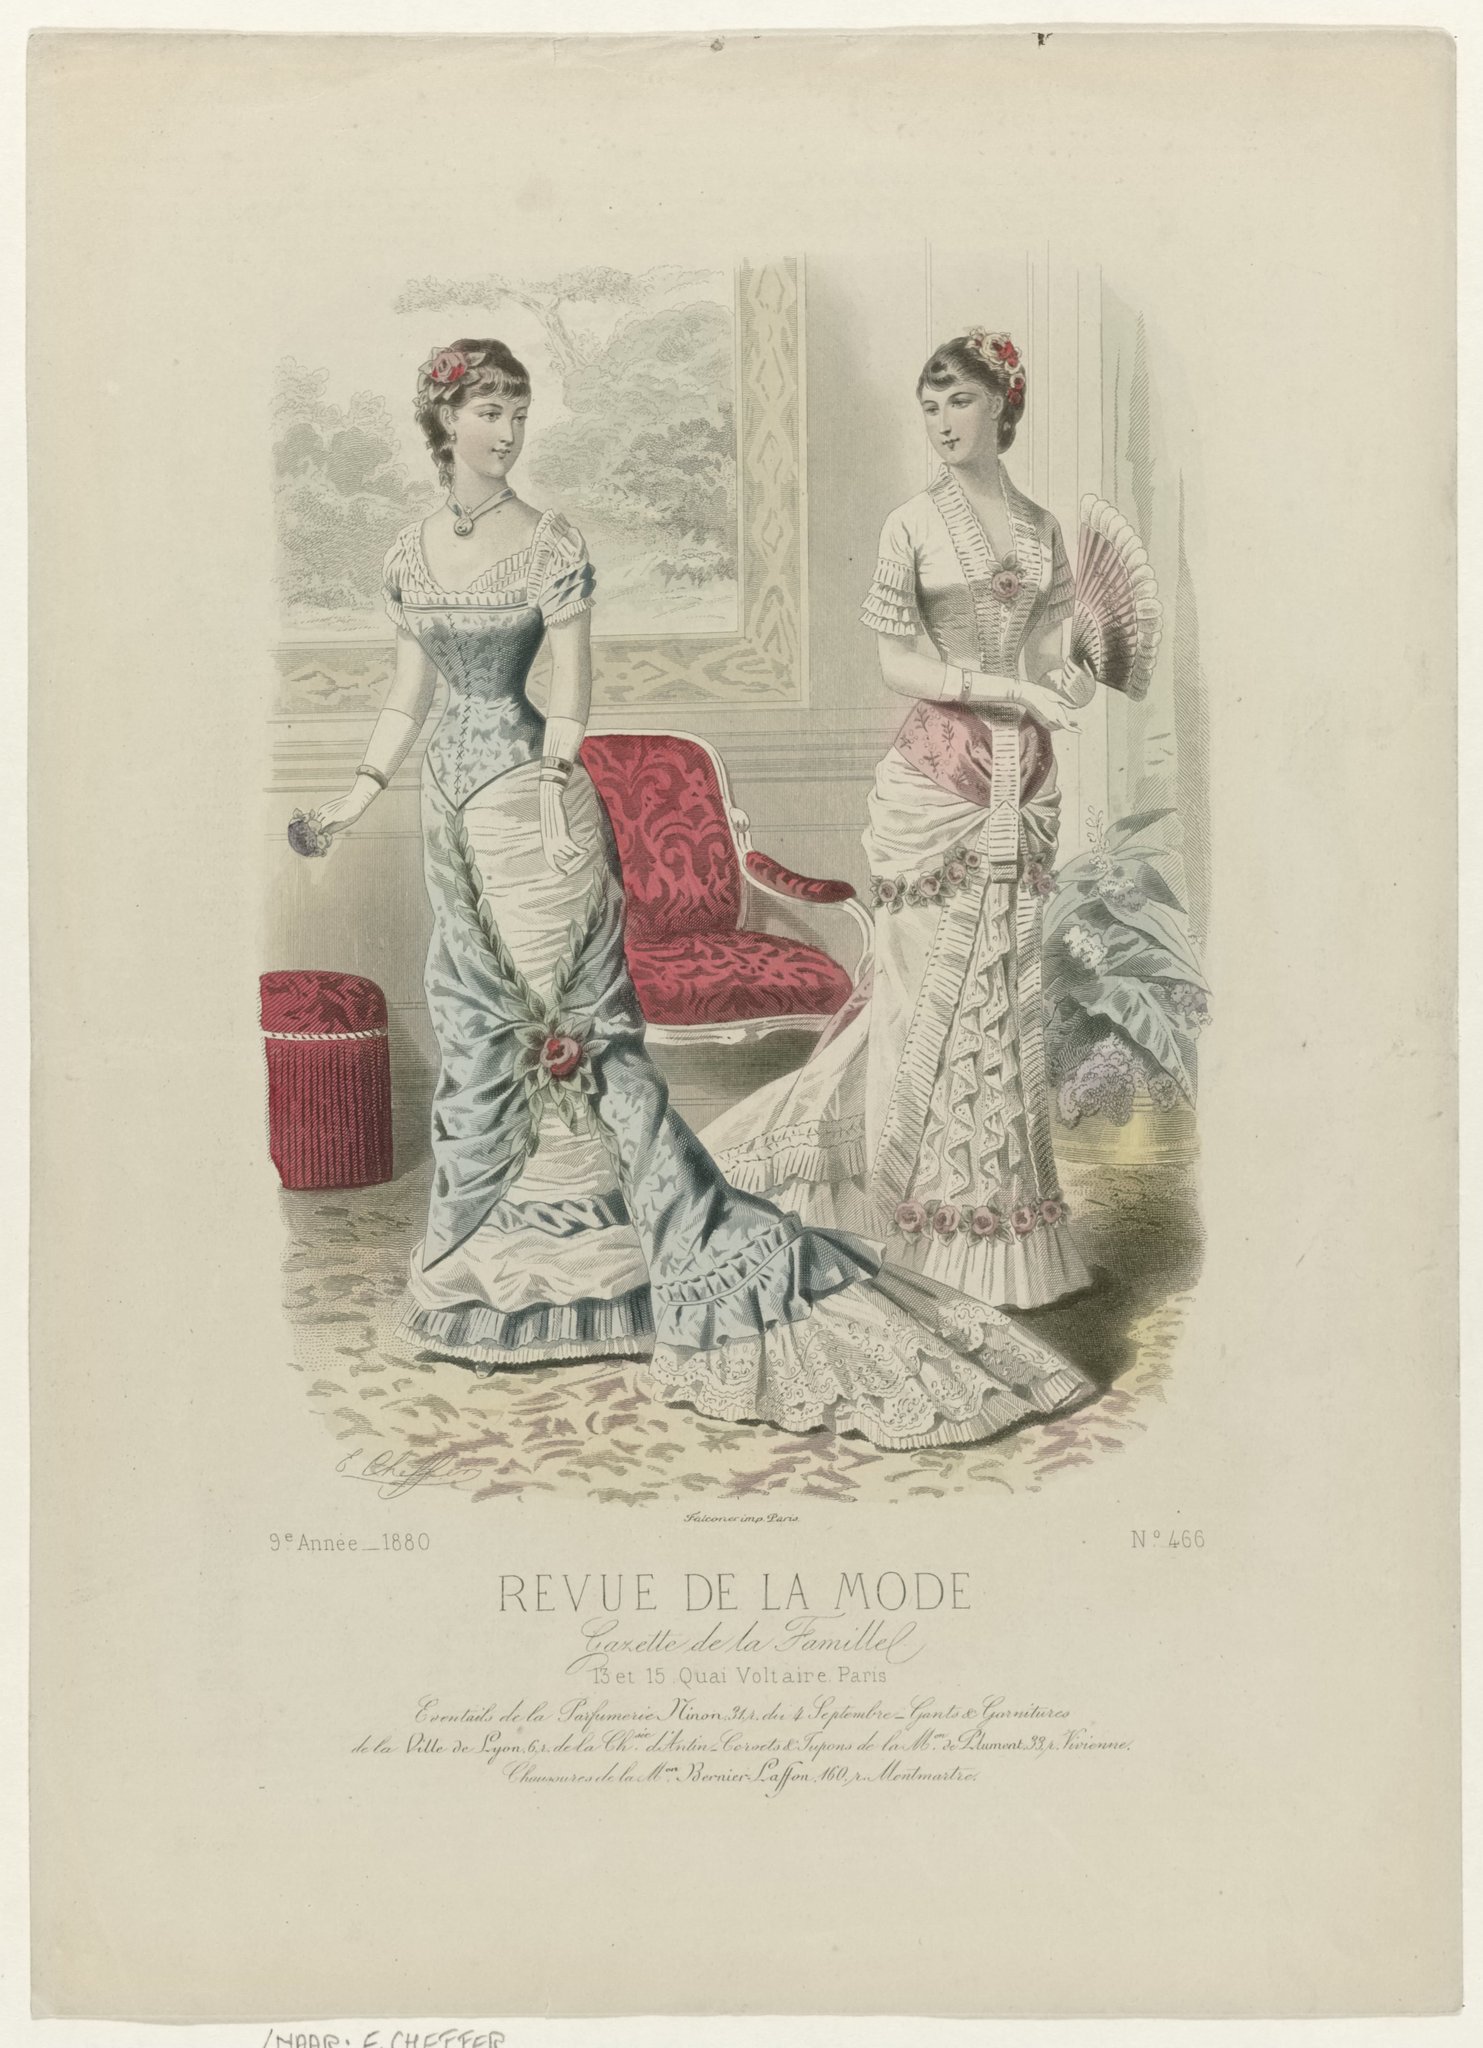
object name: fashion print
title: Revue de la Mode, Gazette de la Famille, dimanche 5 décembre 1880, 9e année, No. 466: Eventails de la Parfumerie Ninon (...)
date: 1880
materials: paper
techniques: engraving, hand coloring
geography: paris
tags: corsage (+ women's clothes), pendant, trinket, 'breloque' (+ women's clothes), gloves, mittens (long gloves) (+ women's clothes), dress, gown: ball gown (+ women's clothes), lace (+ women's clothes), dress, gown: dinner dress (+ women's clothes), fashion plates, fan (+ feathers used for clothes), flowers: rose, bracelet, wristlet (+ women's clothes)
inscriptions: caption: ‘Eventails de la Parfumerie Ninon, 31, r. du 4 Septembre_Gants & Garnitures de la Ville de Lyon, 6, r. de la Ch.sée d'Antin_Corsets & Jupons de la M.on de Plument, 33. r. Vivienne. Chaussures de la M.on Bernier-Laffon, 160, r. Montmartre.’, address: ‘13 et 15, Quai Voltaire, Paris’, title: ‘REVUE DE LA MODE / Gazette de la Famille’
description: Twee vrouwen in een interieur. Links een baljapon in blauw en wit, met een sleep van wit satijn, gegarneerd met witte kant. Rechts: japon van mousseline of witte 'gaze de soie' en lichtroze zijde, bedoeld voor een meisje of jonge vrouw tijdens een receptie of 'grand diner'. Waaier van rode en roze veren van Parfumerie Ninon. Onder de afbeelding enkele regels reclametekst voor verschillende producten. Prent uit het modetijdschrift Revue de la Mode (1872-1913). Uitgebreide beschrijving van de kleding op pagina 403 en 404 "PLANCHE COLORIÉE".